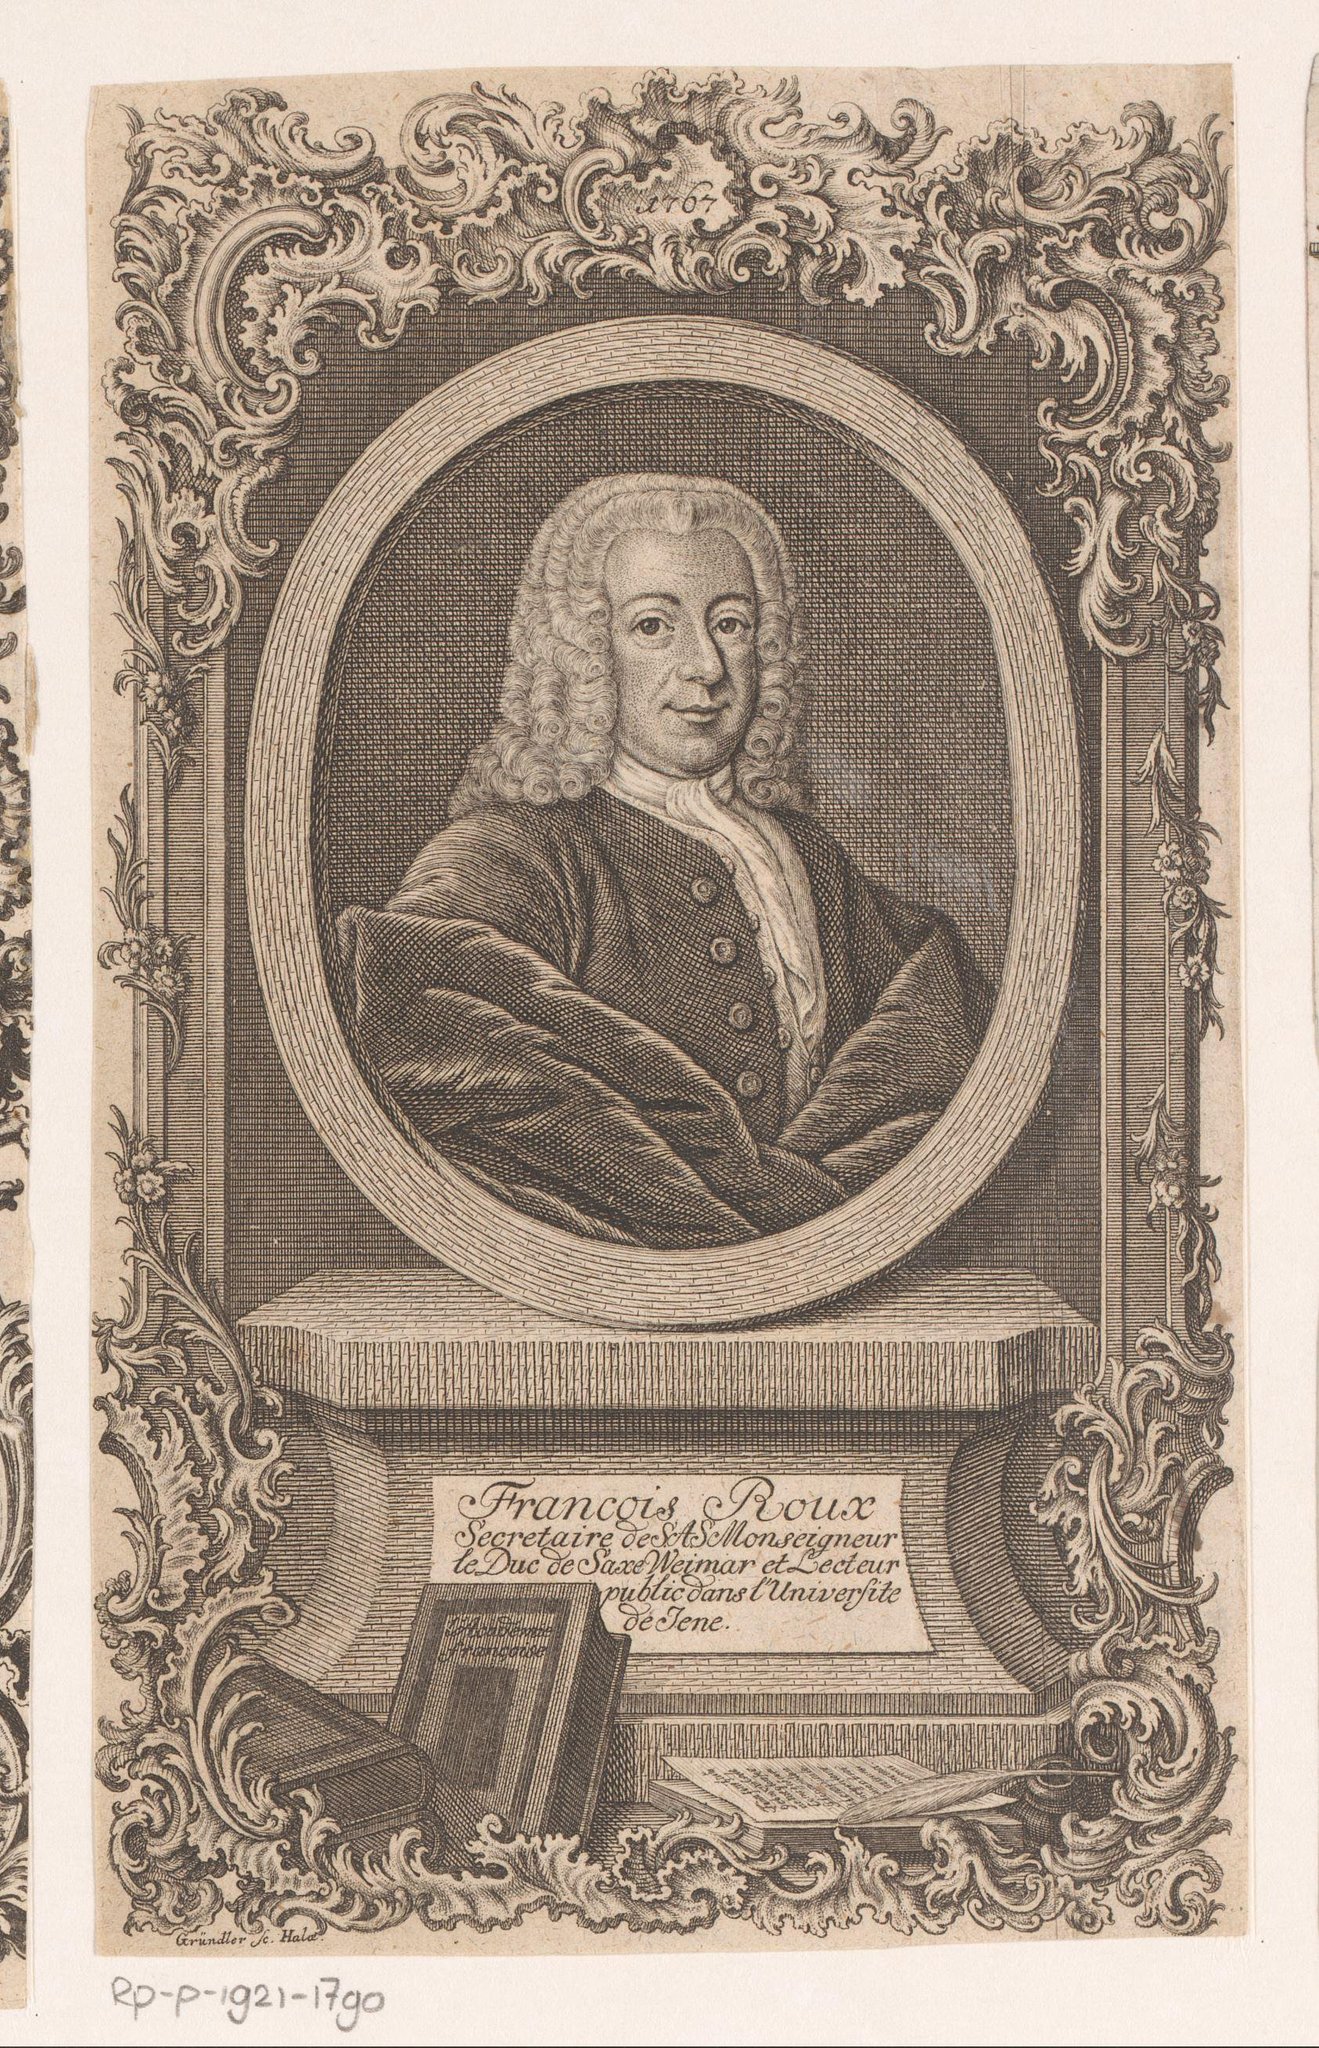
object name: print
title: Portret van François Roux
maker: gottfried august gründler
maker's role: painter, print maker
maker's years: 1710-1775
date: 1720-1750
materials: paper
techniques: engraving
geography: halle an der saale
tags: rocaille ornament, writing tools, historical persons, book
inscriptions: collector's mark: Lugt 2233